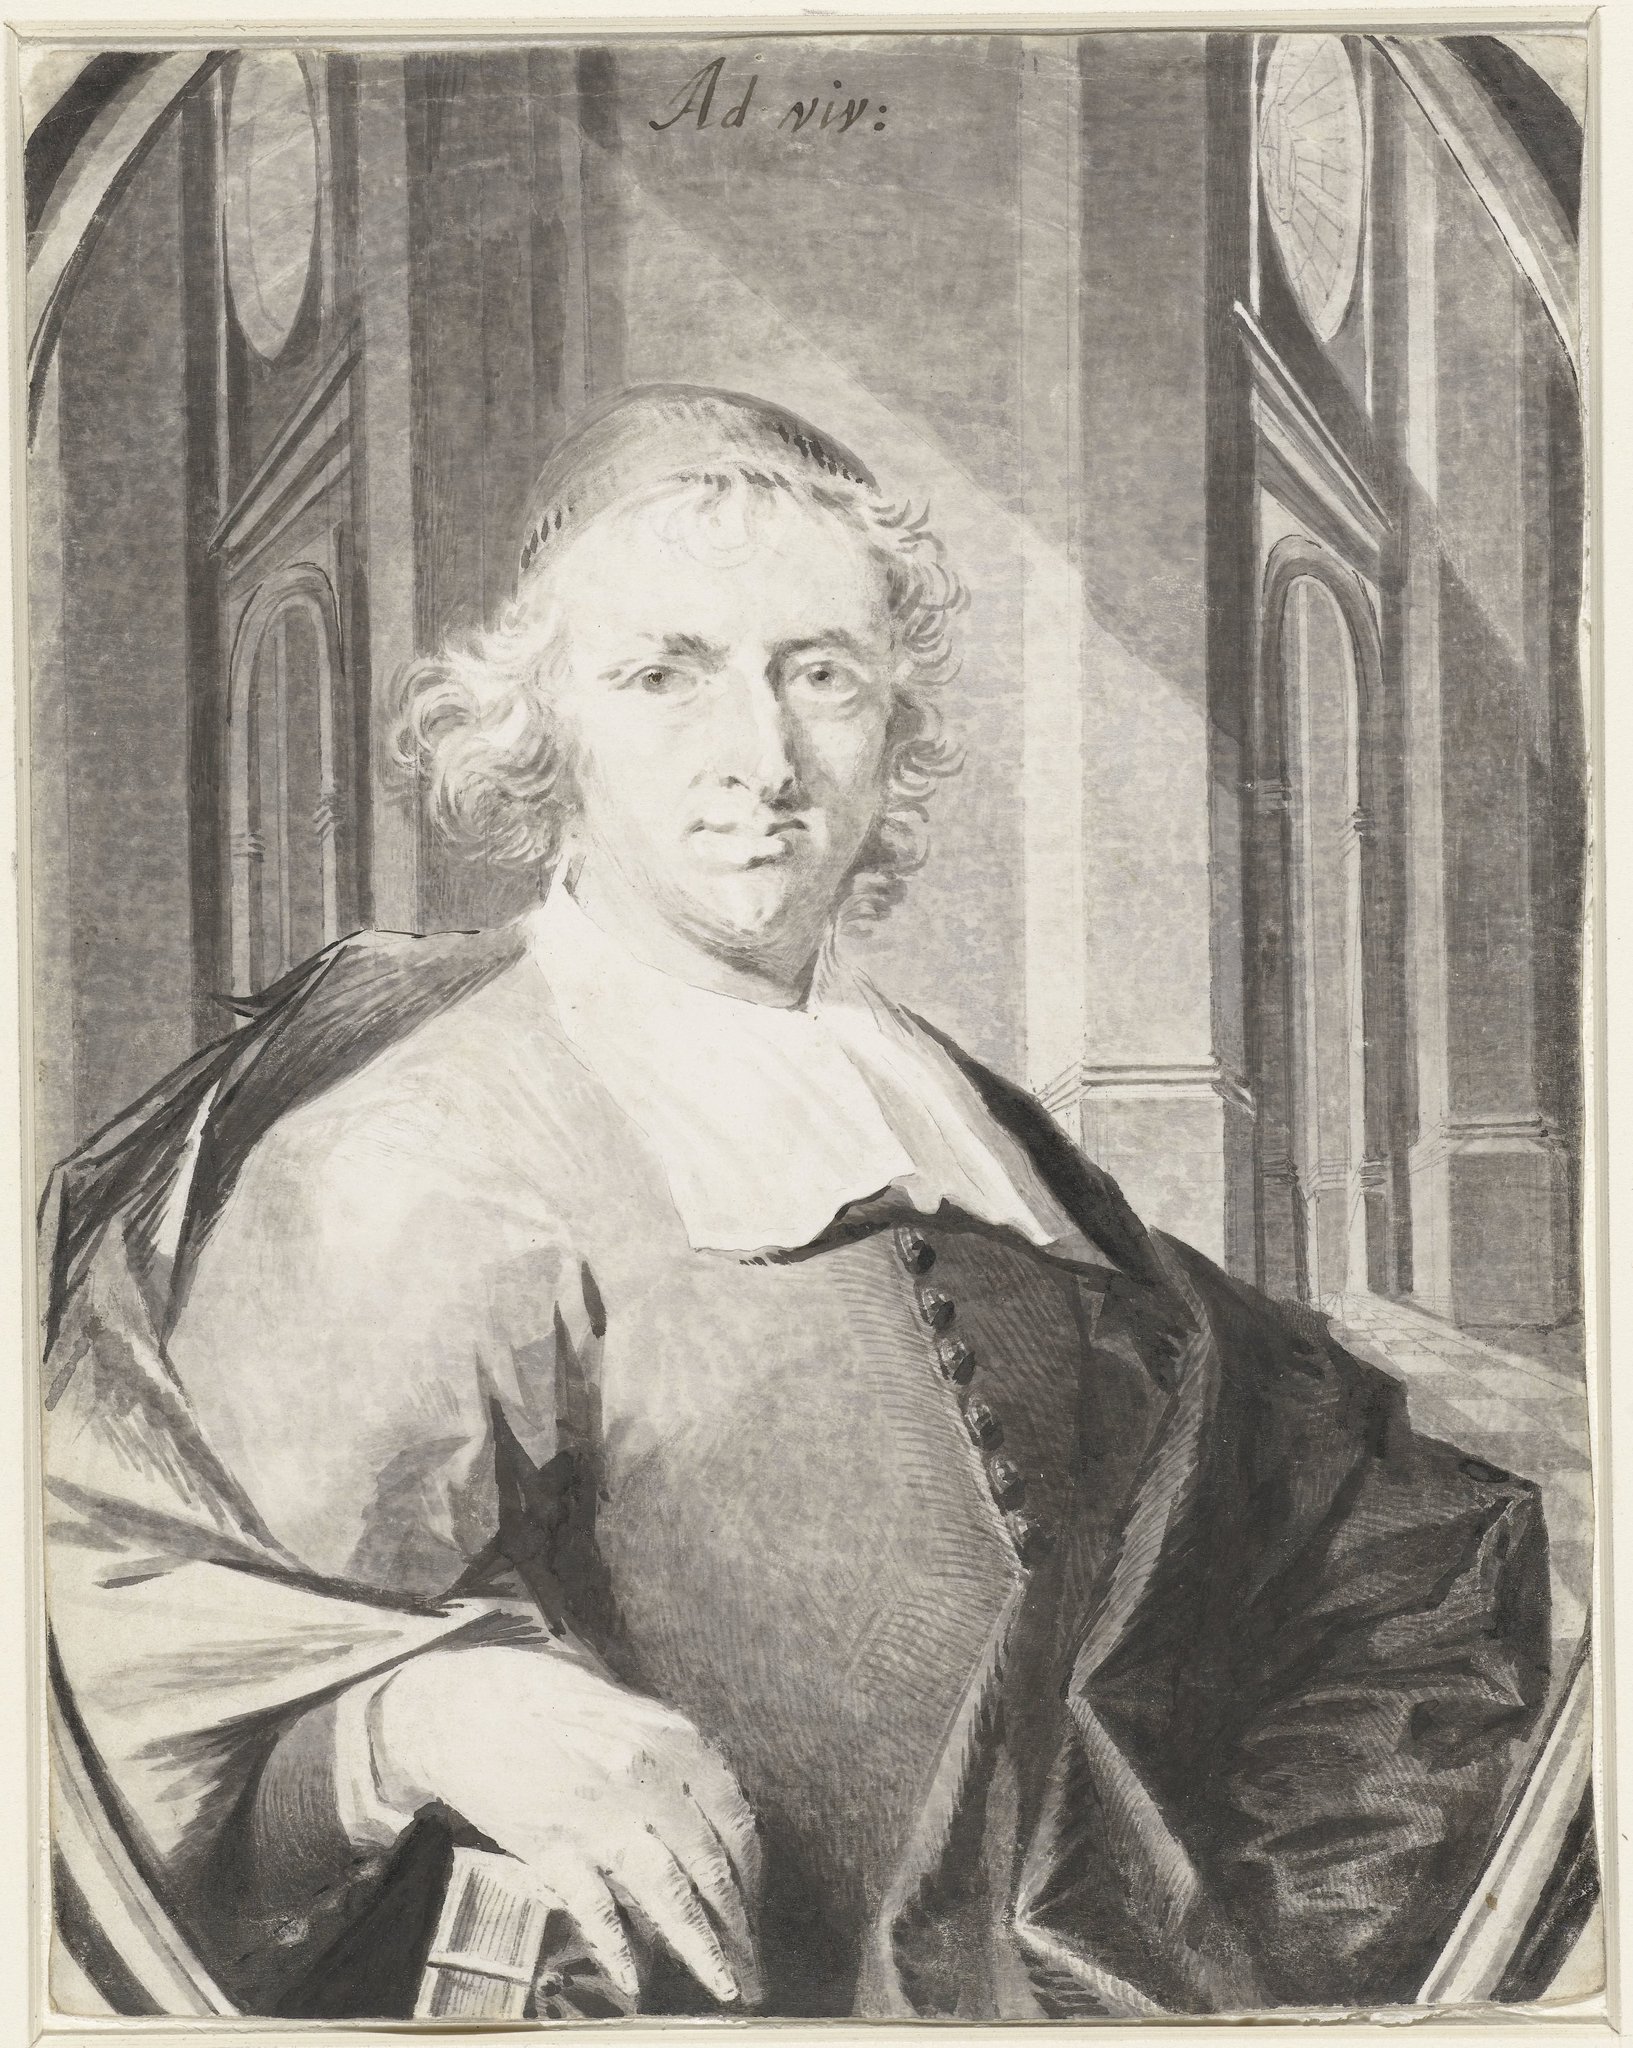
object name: drawing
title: Portret van een onbekende geestelijke, driekwart naar rechts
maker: Anonymous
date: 1700-1800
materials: ink, parchment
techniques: brush, pen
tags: anonymous historical person portrayed alone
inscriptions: : ‘Ad viv:’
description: Portret van een onbekende geestelijke; driekwart naar rechts, de rechterhand steunend op een boek.